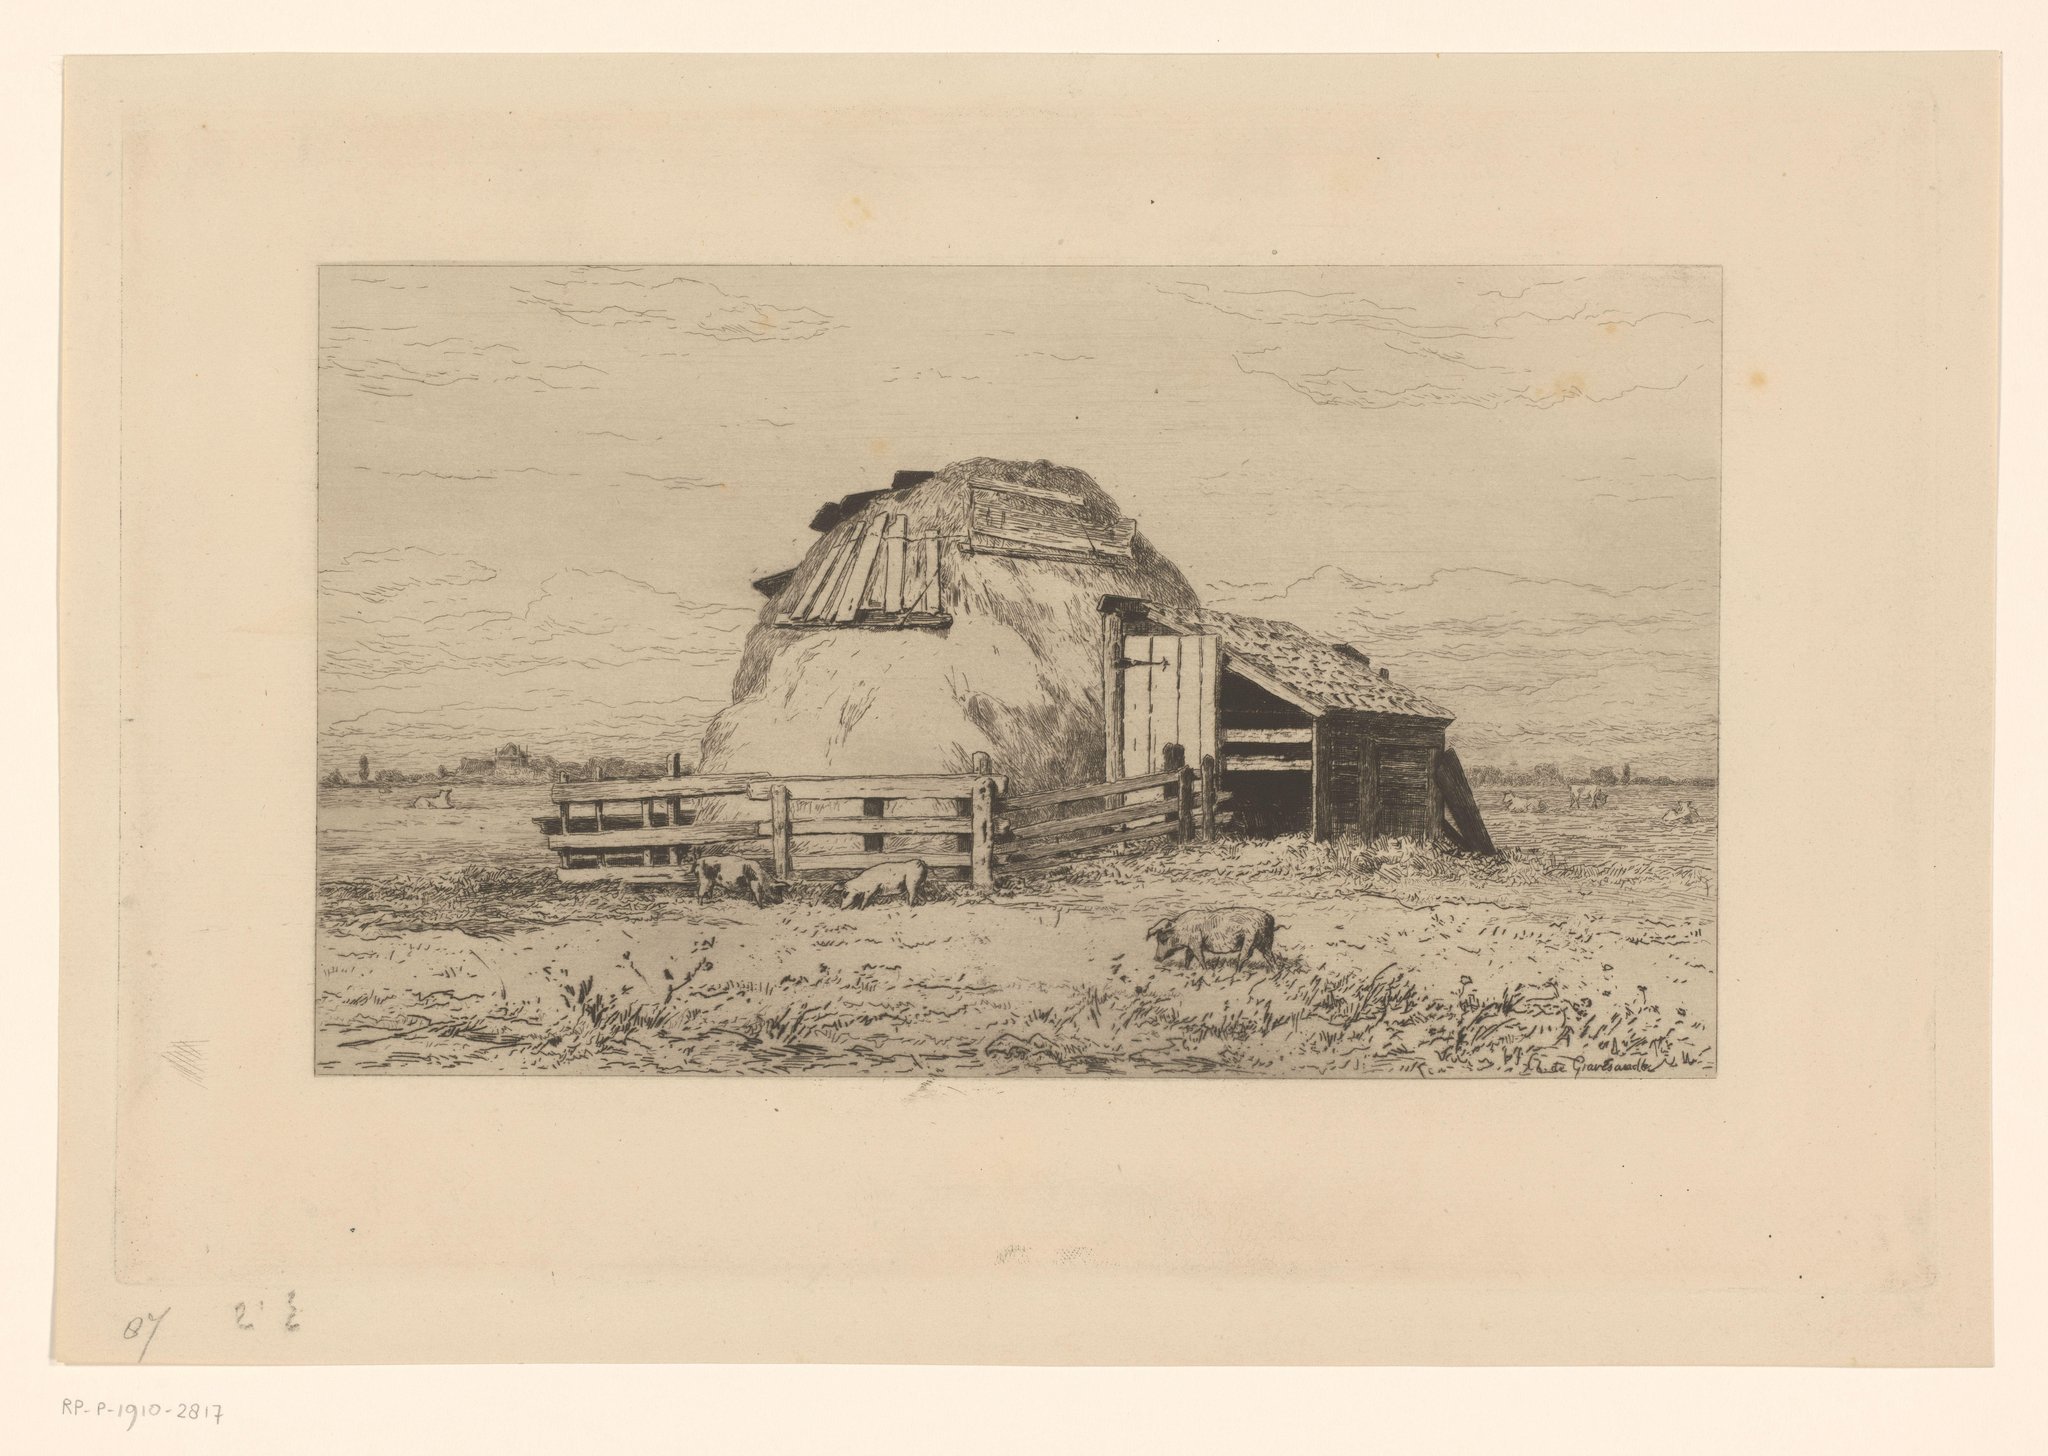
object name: print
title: Meule et étable à cochons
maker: carel nicolaas storm van s-gravesande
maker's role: draughtsman, print maker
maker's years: 1841-1924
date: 1875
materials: paper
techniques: etching, intaglio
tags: pig, stall, stable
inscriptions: collector's mark: Lugt 2228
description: Voor de stal lopen drie grazende varkens in de wei.